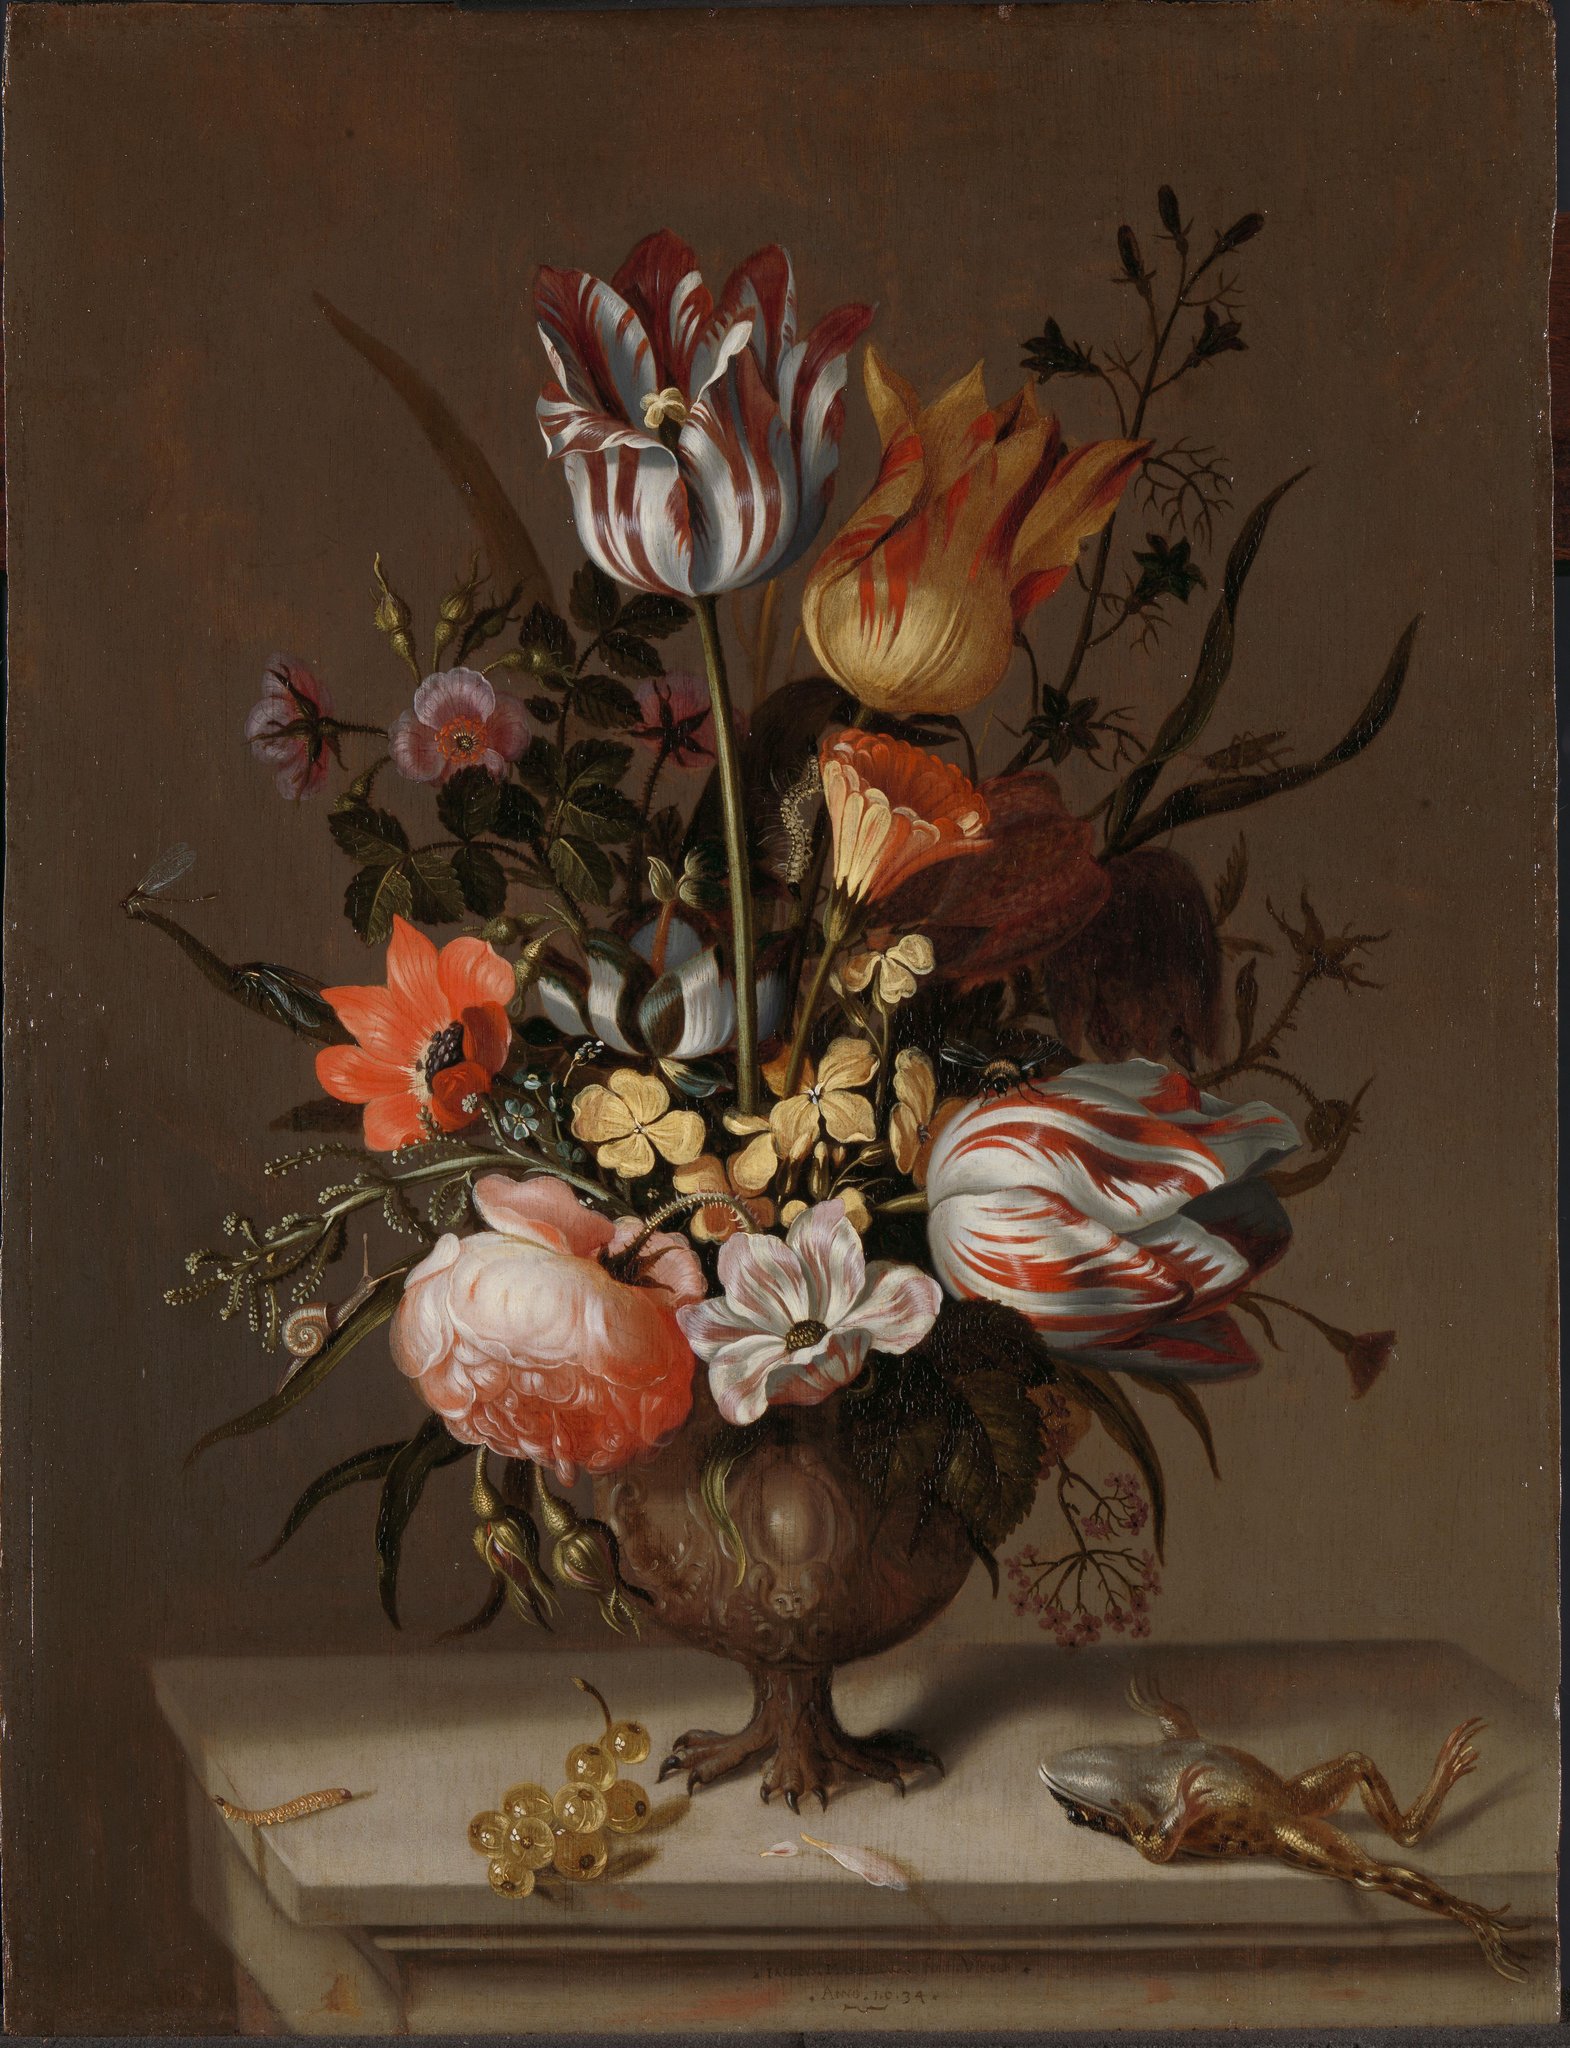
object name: painting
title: Still Life with a Vase of Flowers and a Dead Frog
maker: jacob marrel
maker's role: draughtsman, painter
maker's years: 1614-1681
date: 1634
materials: oil, panel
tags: tailless amphibians (with name) (+ dying animal; death of animal; dead animal), cut flowers; nosegay, bunch of flowers, flowers in a vase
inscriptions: signature, date and inscription, bottom centre, on the table in the foreground: ‘.IACOBVS.MARRELLVS.fecit.VtRECk. / .ANNO.1.6.34.’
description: Jacob Marrel’s specialized in ‘portraits’ of tulips in bloom. Tulip bulbs were collected fanatically in 17th-century Holland, and astronomical prices were sometimes paid for a single bulb. In this painting as well, tulips play a leading role. The whimsically shaped red-and-white and red-and-yellow striped tulips were especially prized. Although nature creates them, it also lets them wither and die – just like the dead frog at the right.